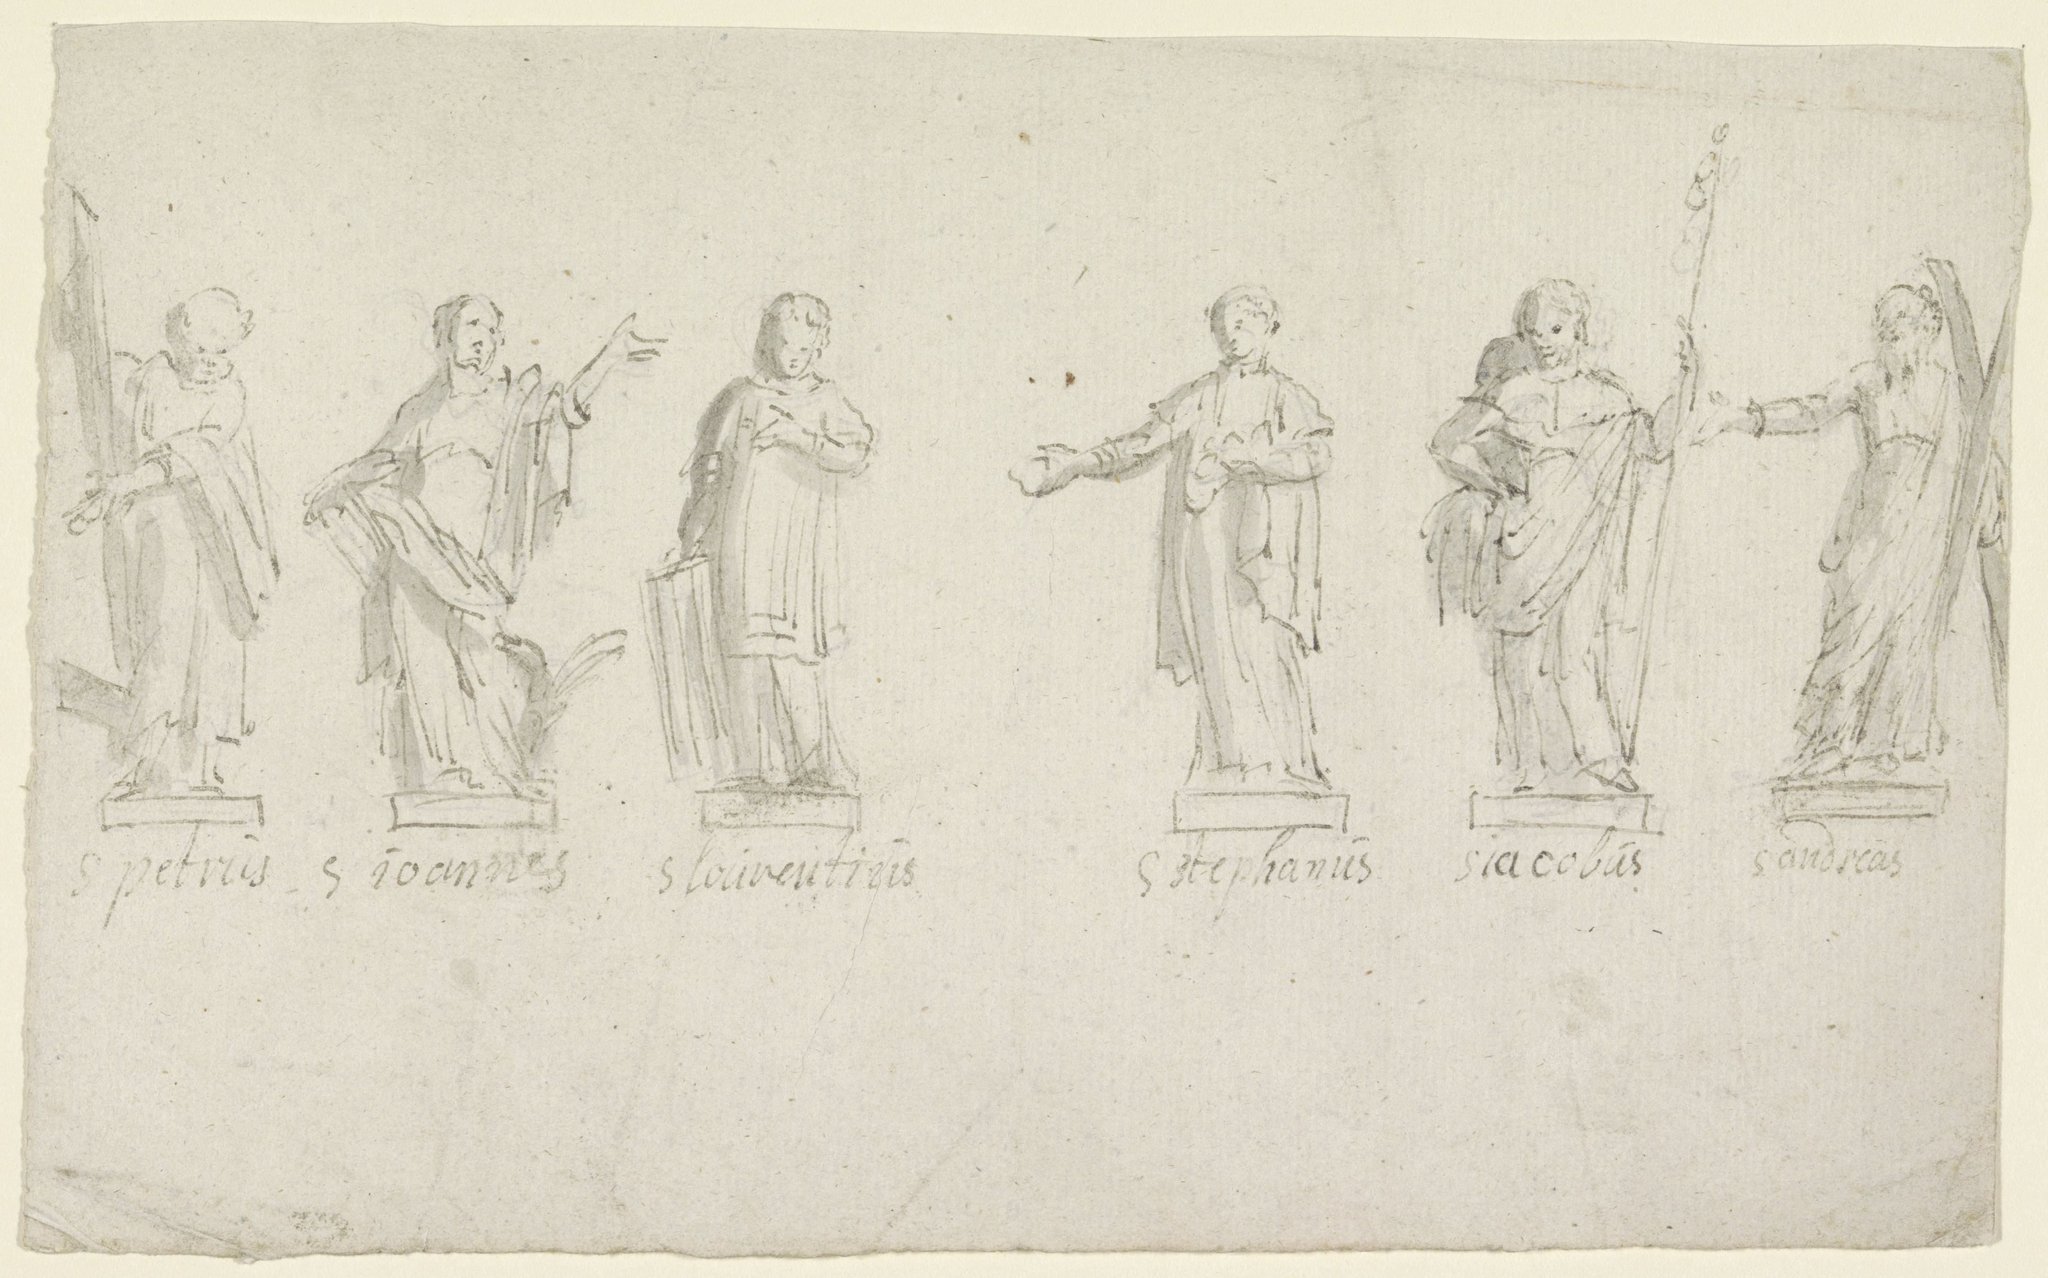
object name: ornamenttekening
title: s petrus, s ioannes, s lourentius, s stephanus, s iacobus, s andreas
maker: Anonymous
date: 1600-1800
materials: ink, paper, pencil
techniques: brush, pen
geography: netherlands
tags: the apostle john the evangelist; possible attributes: book, cauldron, chalice with snake, eagle, palm, scroll, the apostle andrew; possible attributes: book, x-shaped cross, fish, fishing-net, rope, scroll, the deacon and (proto)martyr stephen; possible attributes: censer, stones, the martyr and deacon laurence of rome; possible attributes: book, censer, cross, dalmatic, gridiron, palm, purse (or cup with golden coins), the apostle james the great; possible attributes: book, pilgrim's cloak, hat, shell, staff, and wallet, scroll, sword, the apostle peter, first bishop of rome; possible attributes: book, cock, (upturned) cross, (triple) crozier, fish, key, scroll, ship, tiara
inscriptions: collector's mark: Lugt 2228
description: Zes beelden van heiligen: Petrus met het Petruskruis, Johannes met een adelaar, Laurentius met een rooster, Stefanus met stenen, Jacobus met pelgrimsstaf en Andreas met het Andreaskruis.